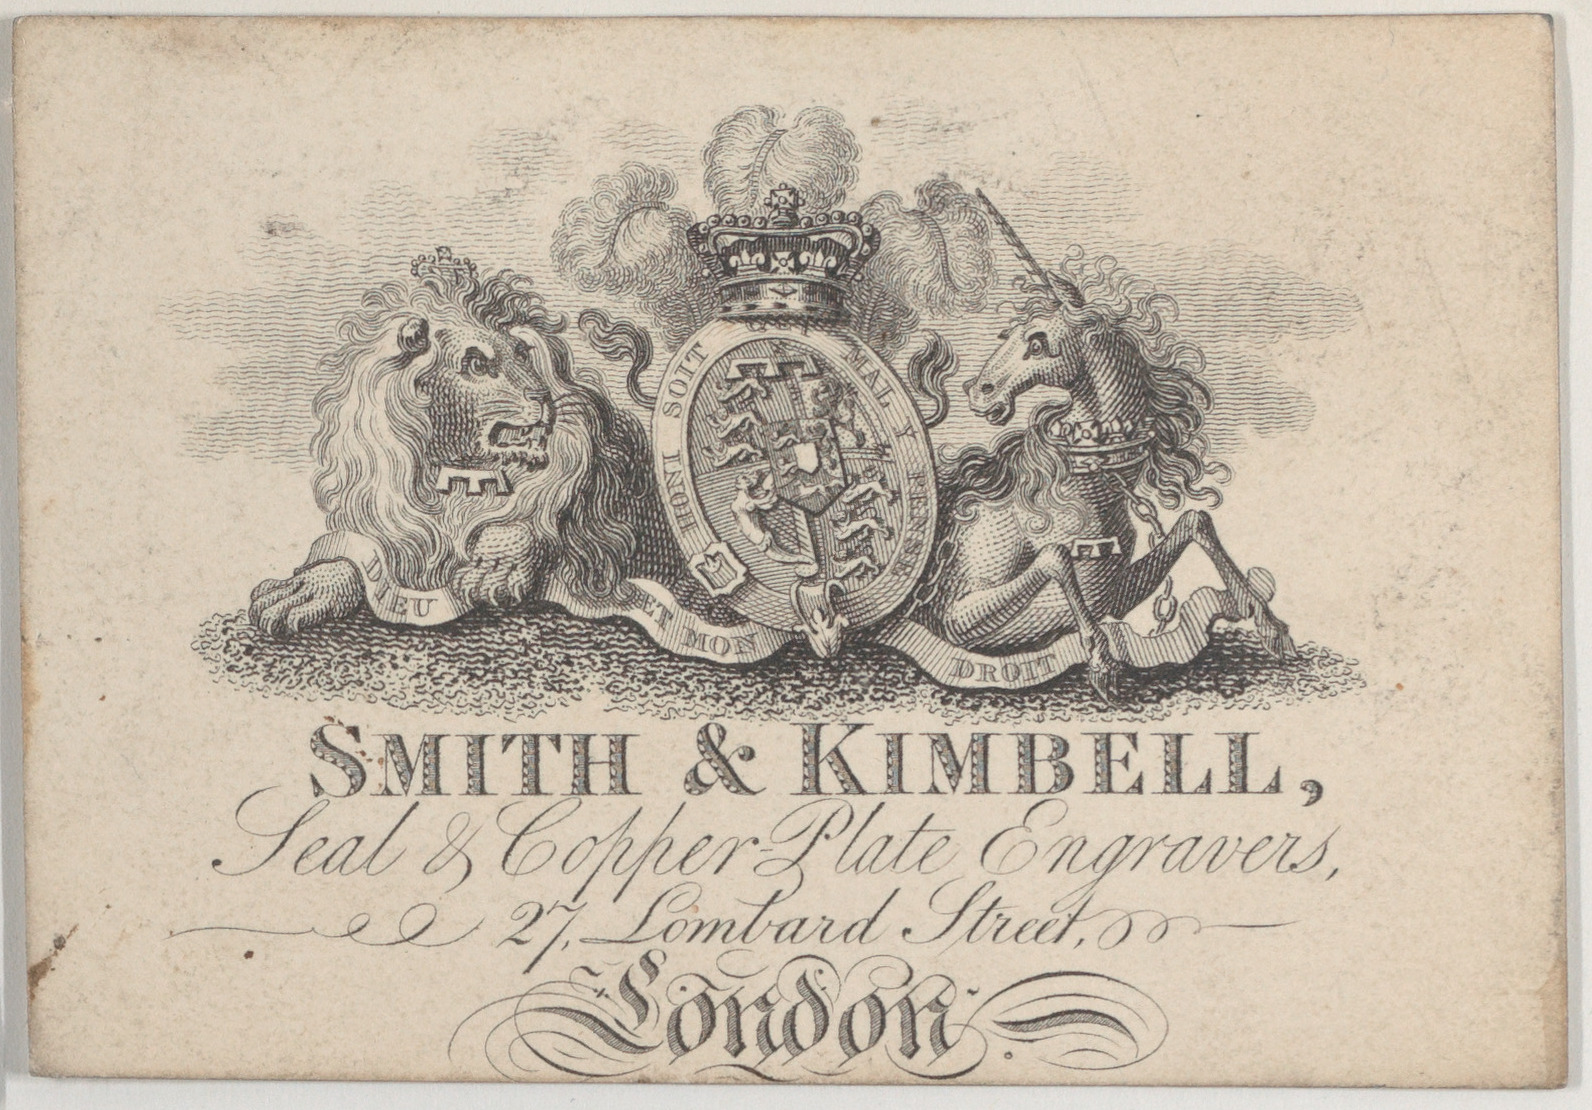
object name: print, trade card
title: Trade Card for Smith & Kimbell, seal and copper plate engravers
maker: anonymous, british, 18th century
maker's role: artist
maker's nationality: british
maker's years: 1700-1800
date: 1701-1800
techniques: engraving